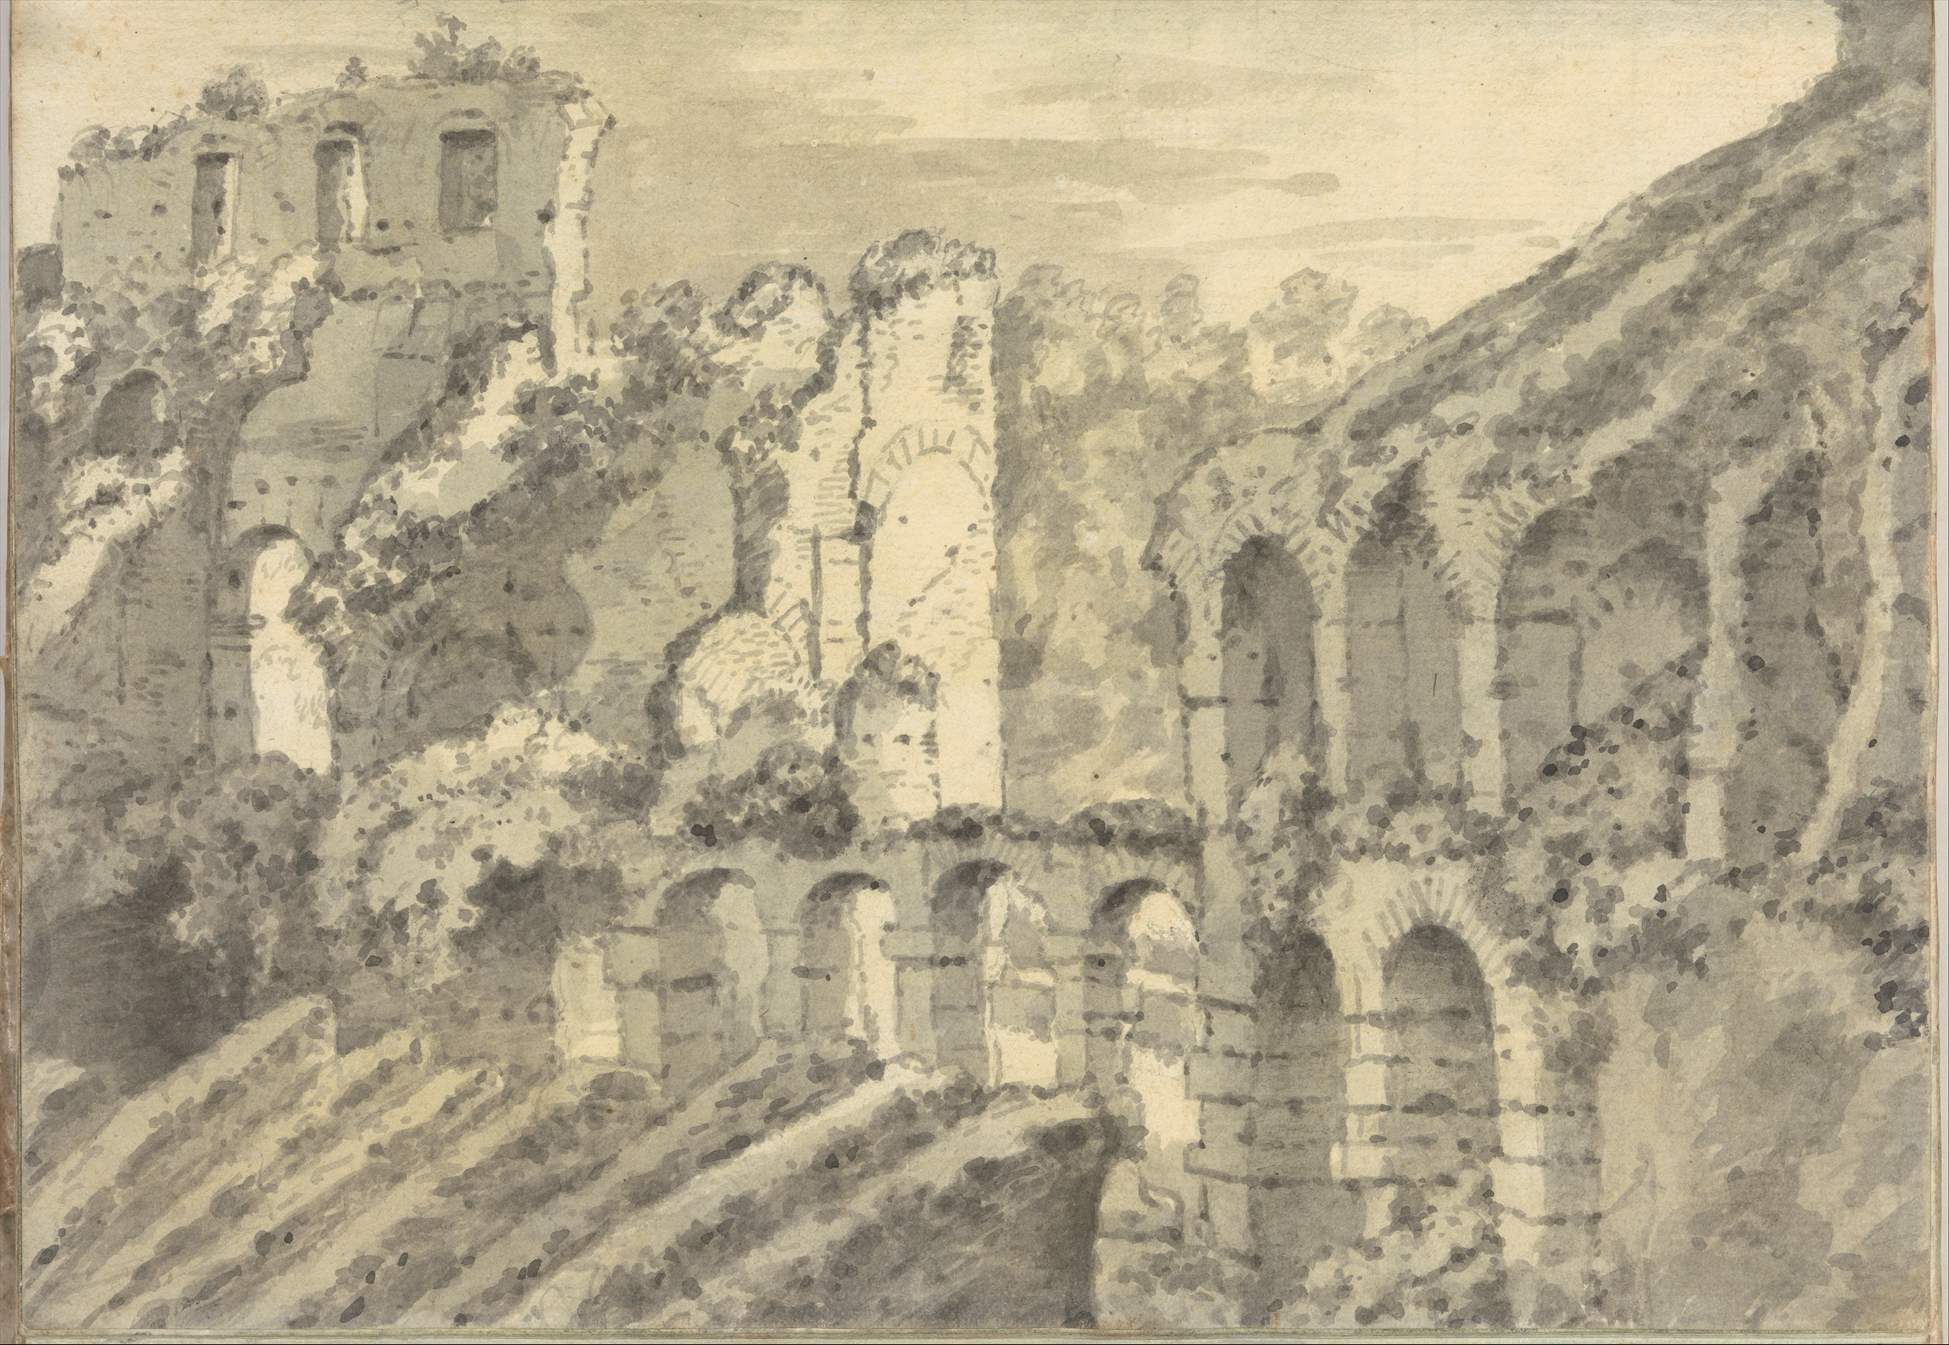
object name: drawing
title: Part of the Colosseum at Rome (Smaller Italian sketchbook, leaf 11 recto)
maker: joseph wright (wright of derby)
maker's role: artist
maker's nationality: british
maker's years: 1734-1797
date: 1774-1775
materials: ink, watercolor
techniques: brush, pen, wash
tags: ruins